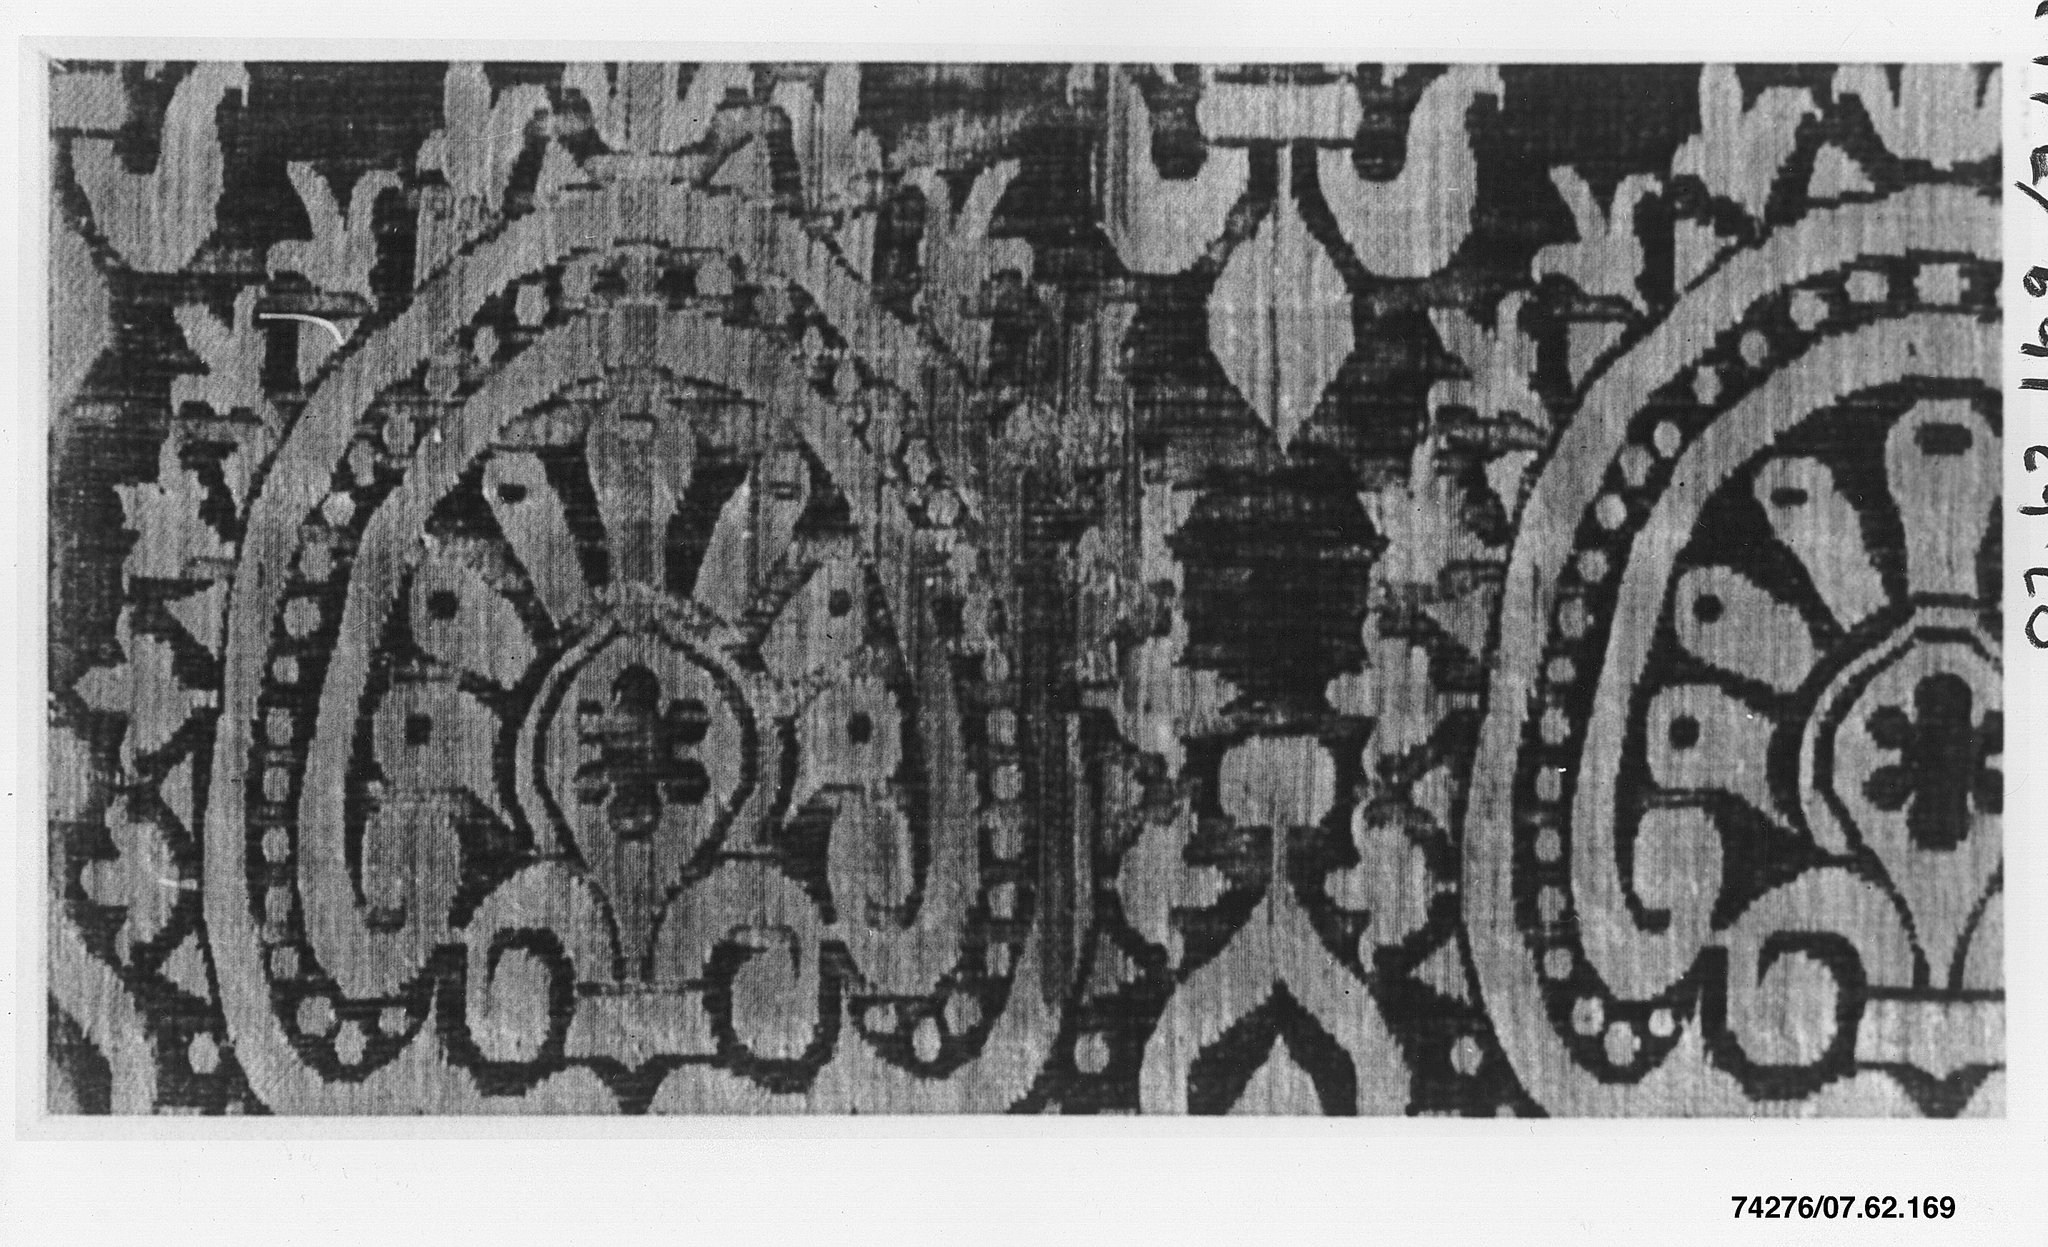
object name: piece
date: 1601-1800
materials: linen, silk